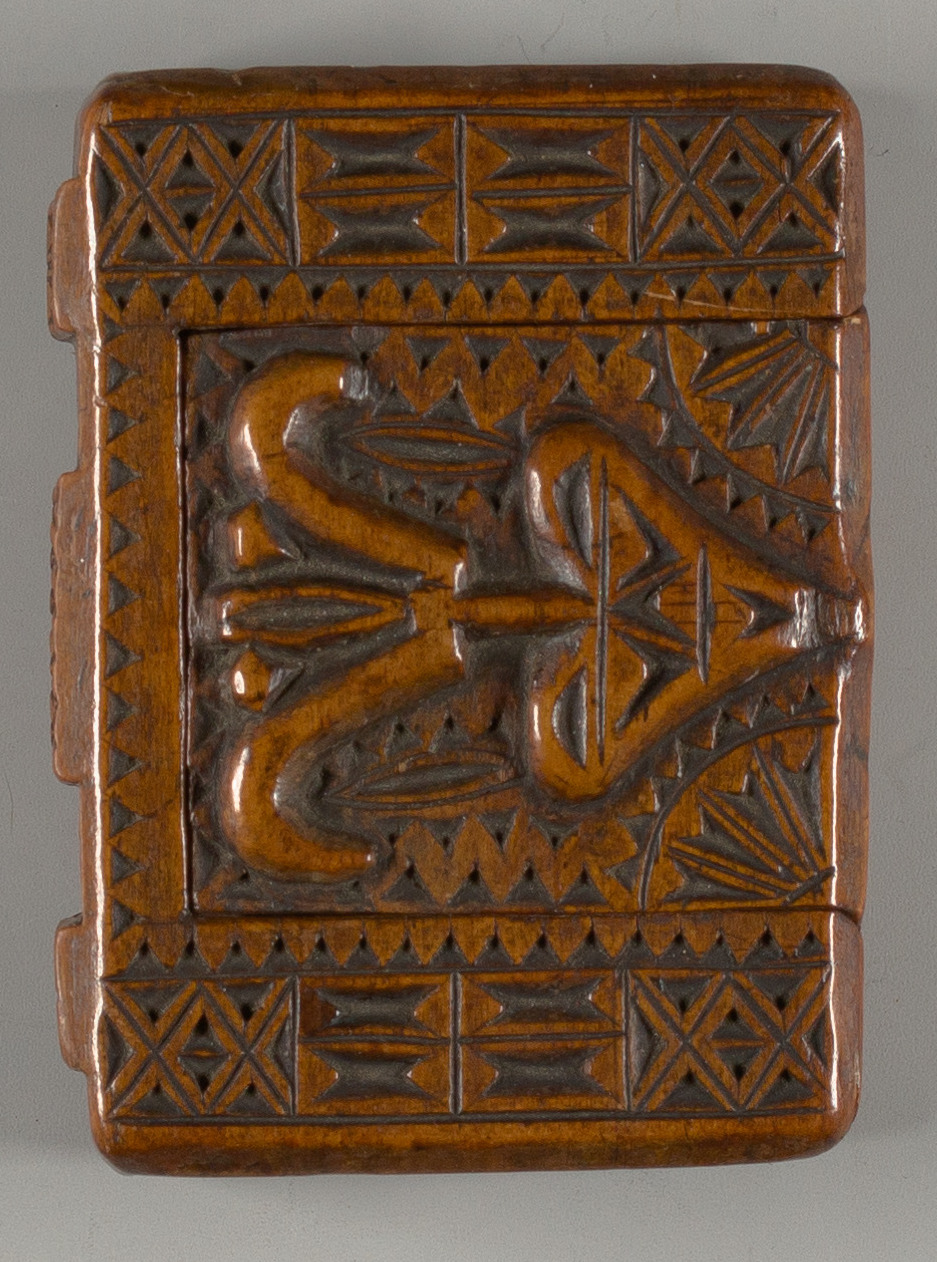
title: Box with tulip and hearts motif in book form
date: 1714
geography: europe